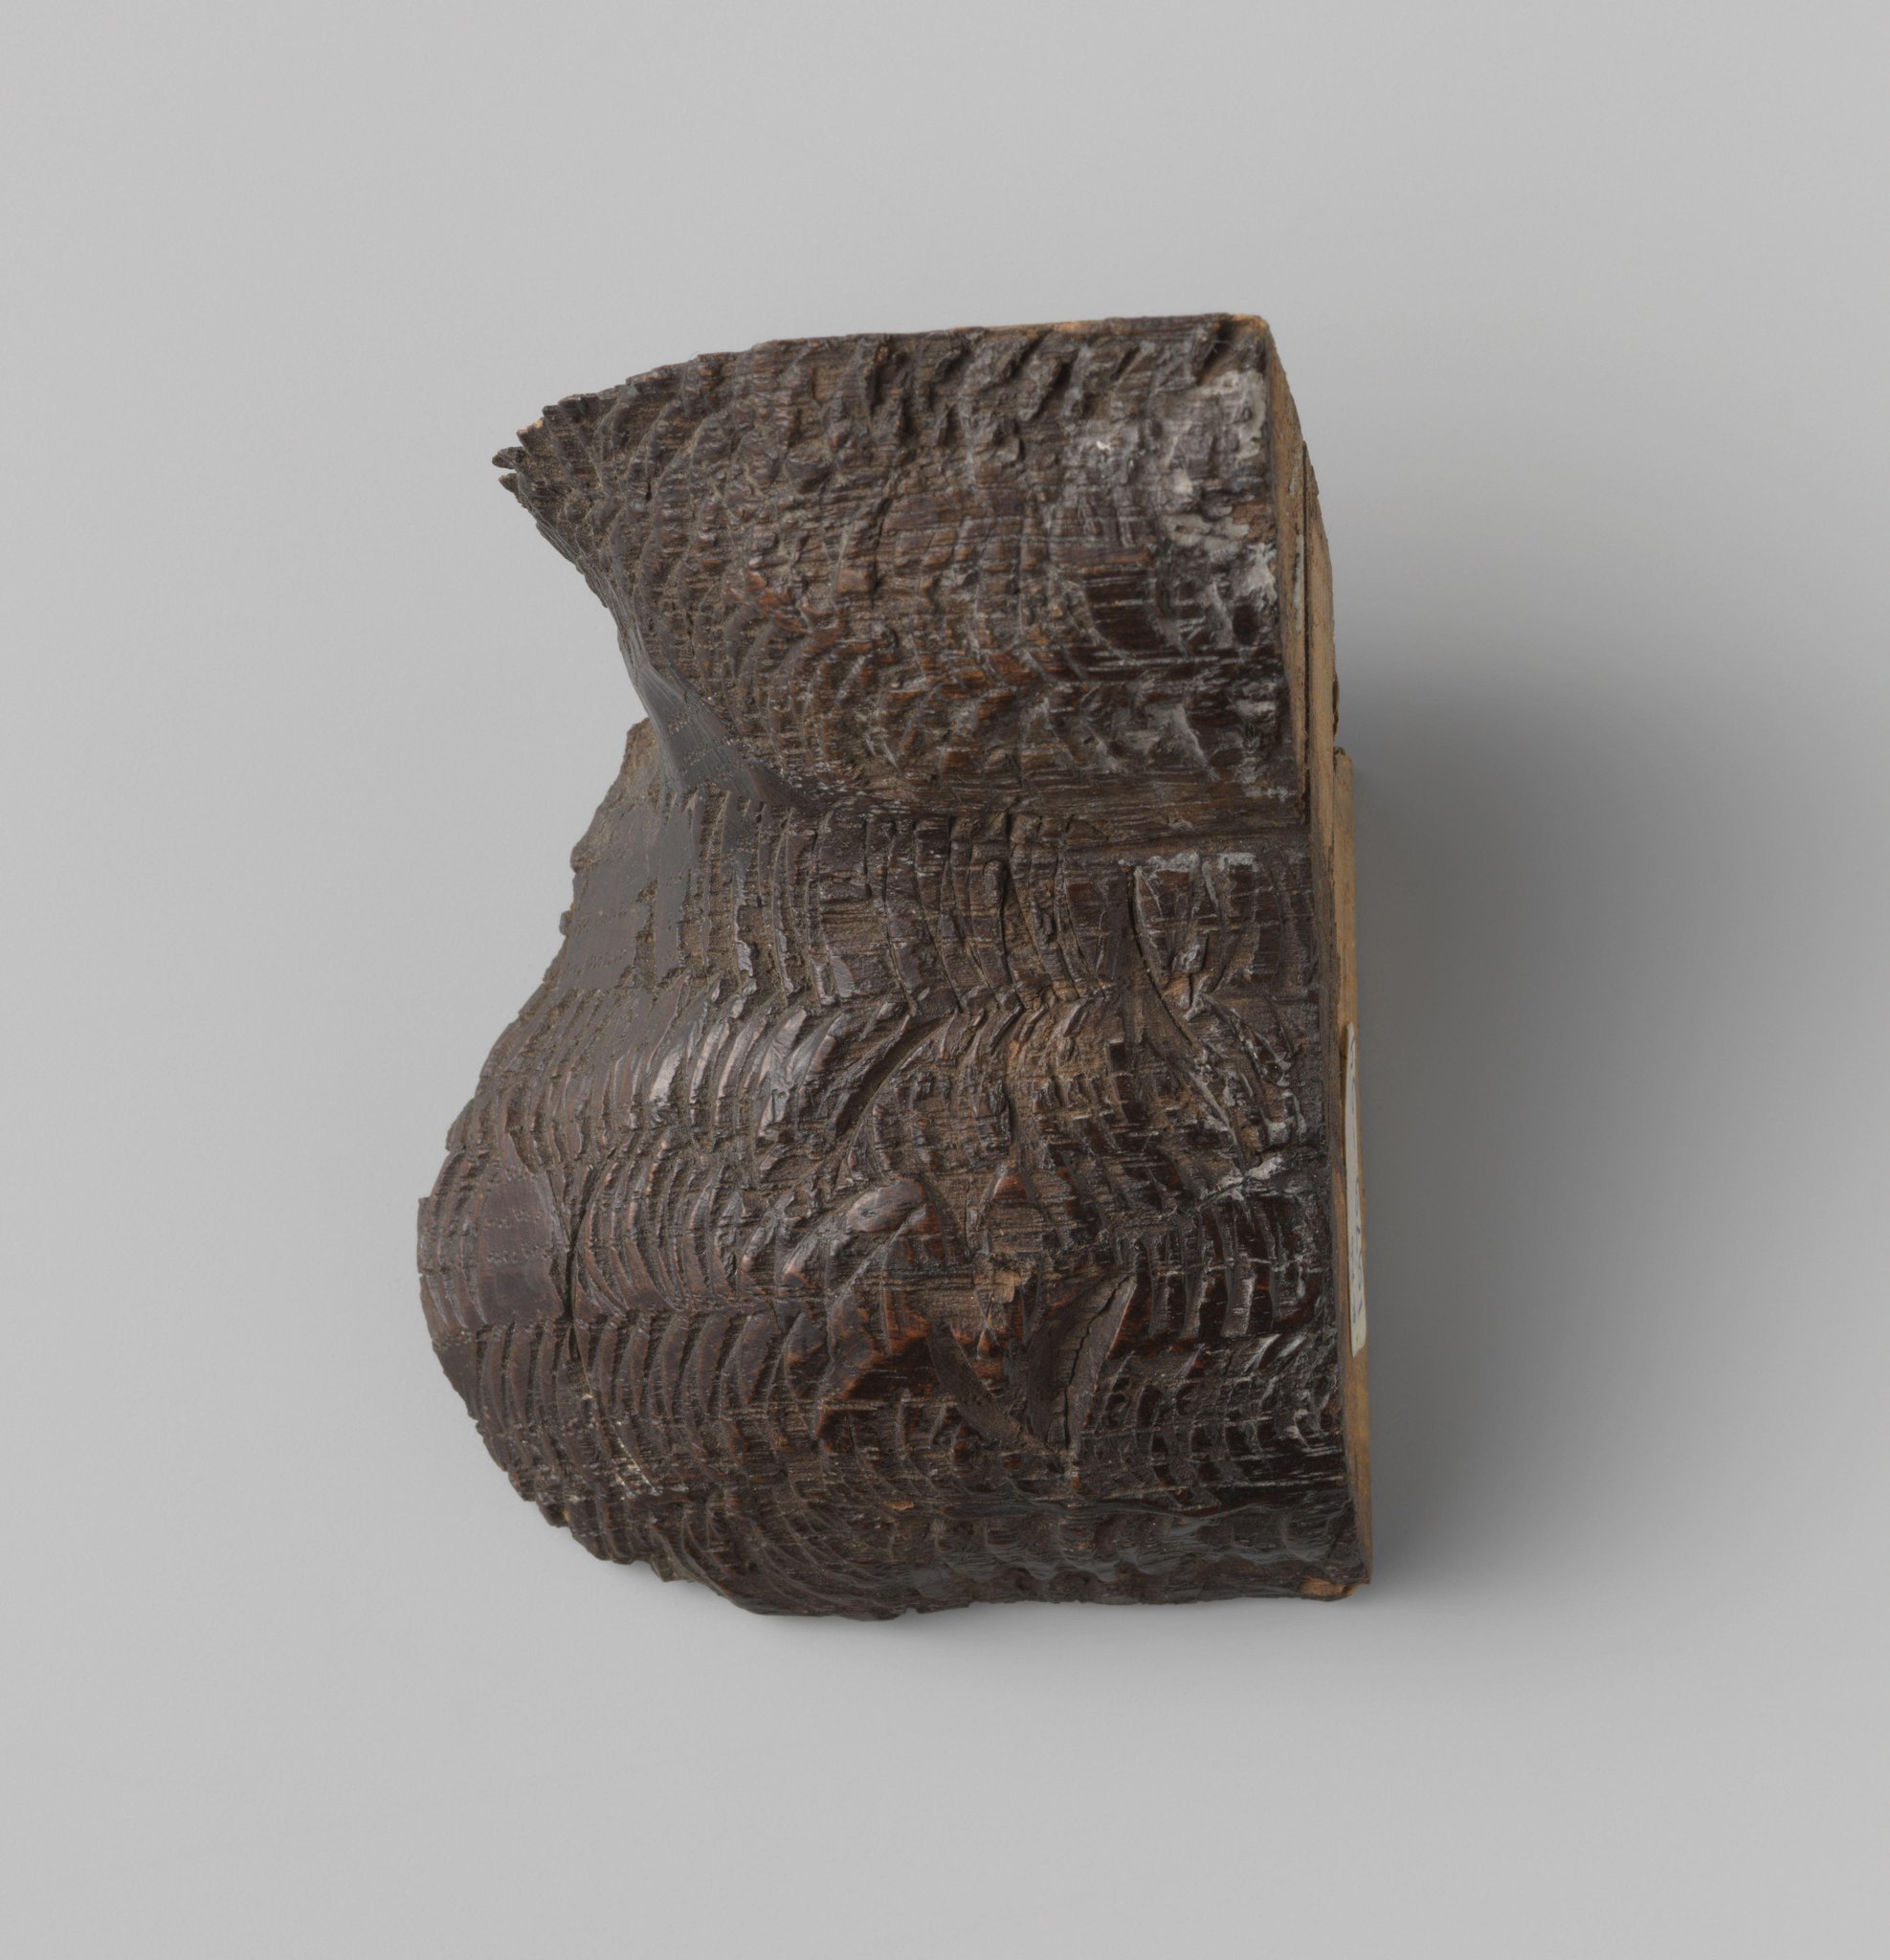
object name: fragment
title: Fragment van de Kruisiging:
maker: adriaen van wesel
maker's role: sculptor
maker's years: 1415-1490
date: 1475-1477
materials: wood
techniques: gilding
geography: utrecht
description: Waarschijnlijk later toegevoegd fragment, na restauratie verwijderd.